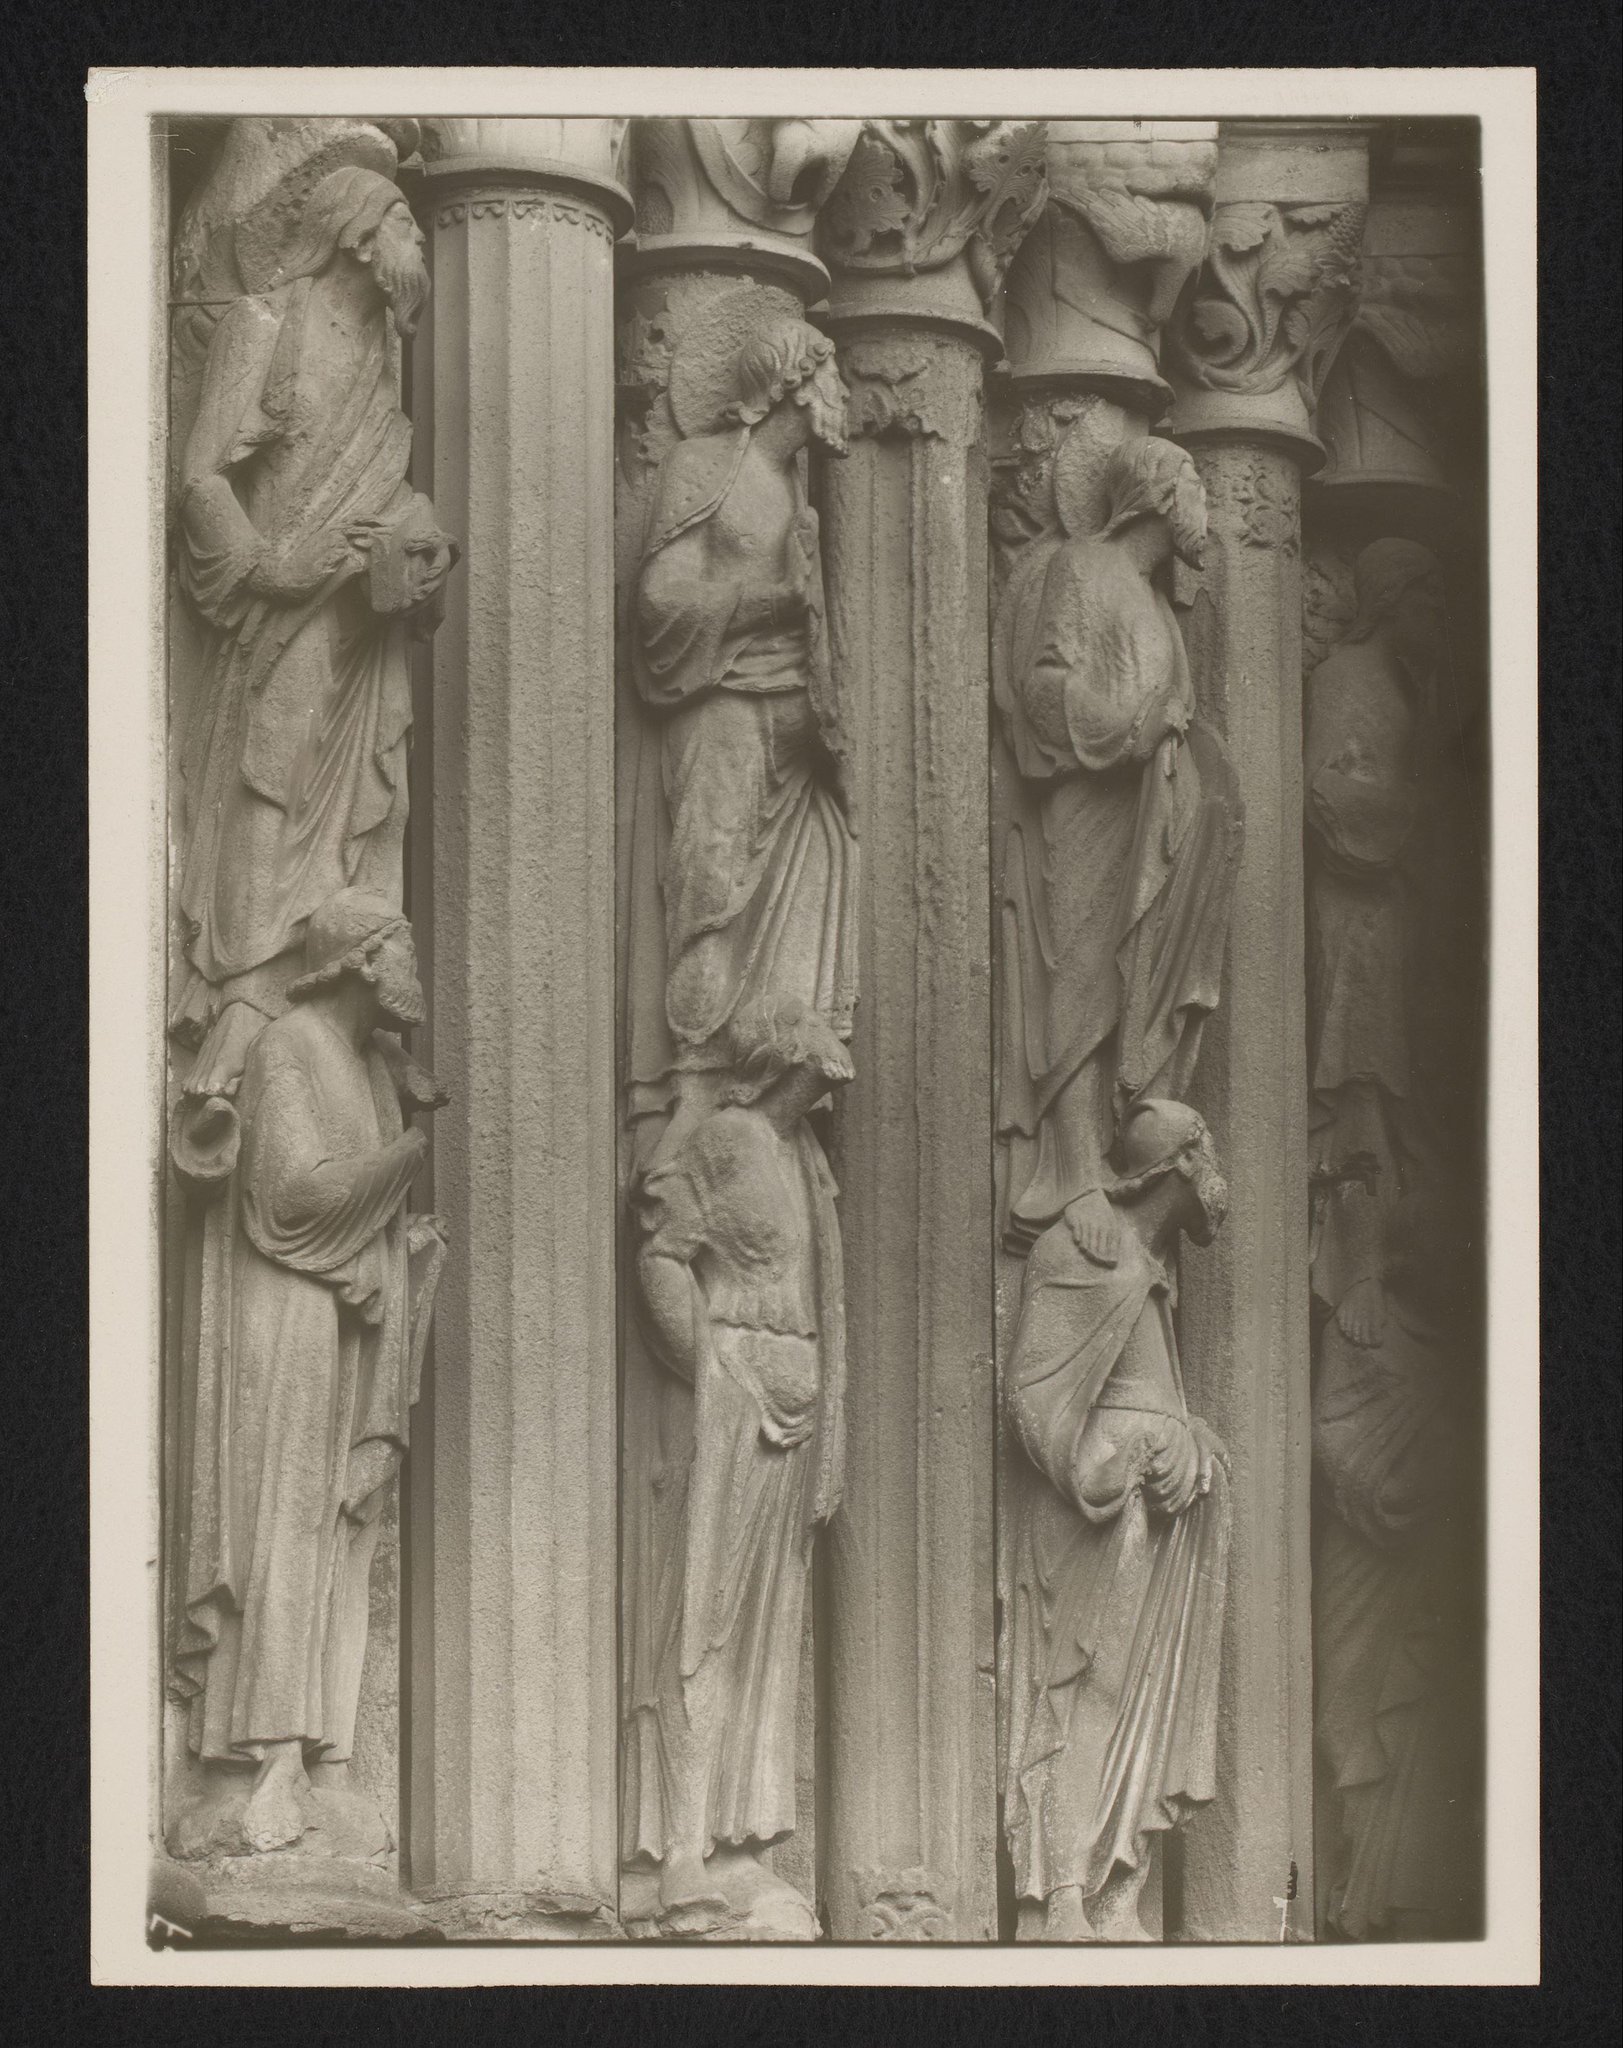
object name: photograph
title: Detail van de Fürstenportal in de dom van Bamberg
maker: Anonymous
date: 1900-1920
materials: paper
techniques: gelatin silver print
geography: bamberg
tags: church (exterior)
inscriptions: inscription: ‘67/ Bamberg’, inscription: ‘Kunsthist. Seminar/ Marburg (Lahn)/ Photogr. Abteilung/ Vervielfältigung/ untersagt.’